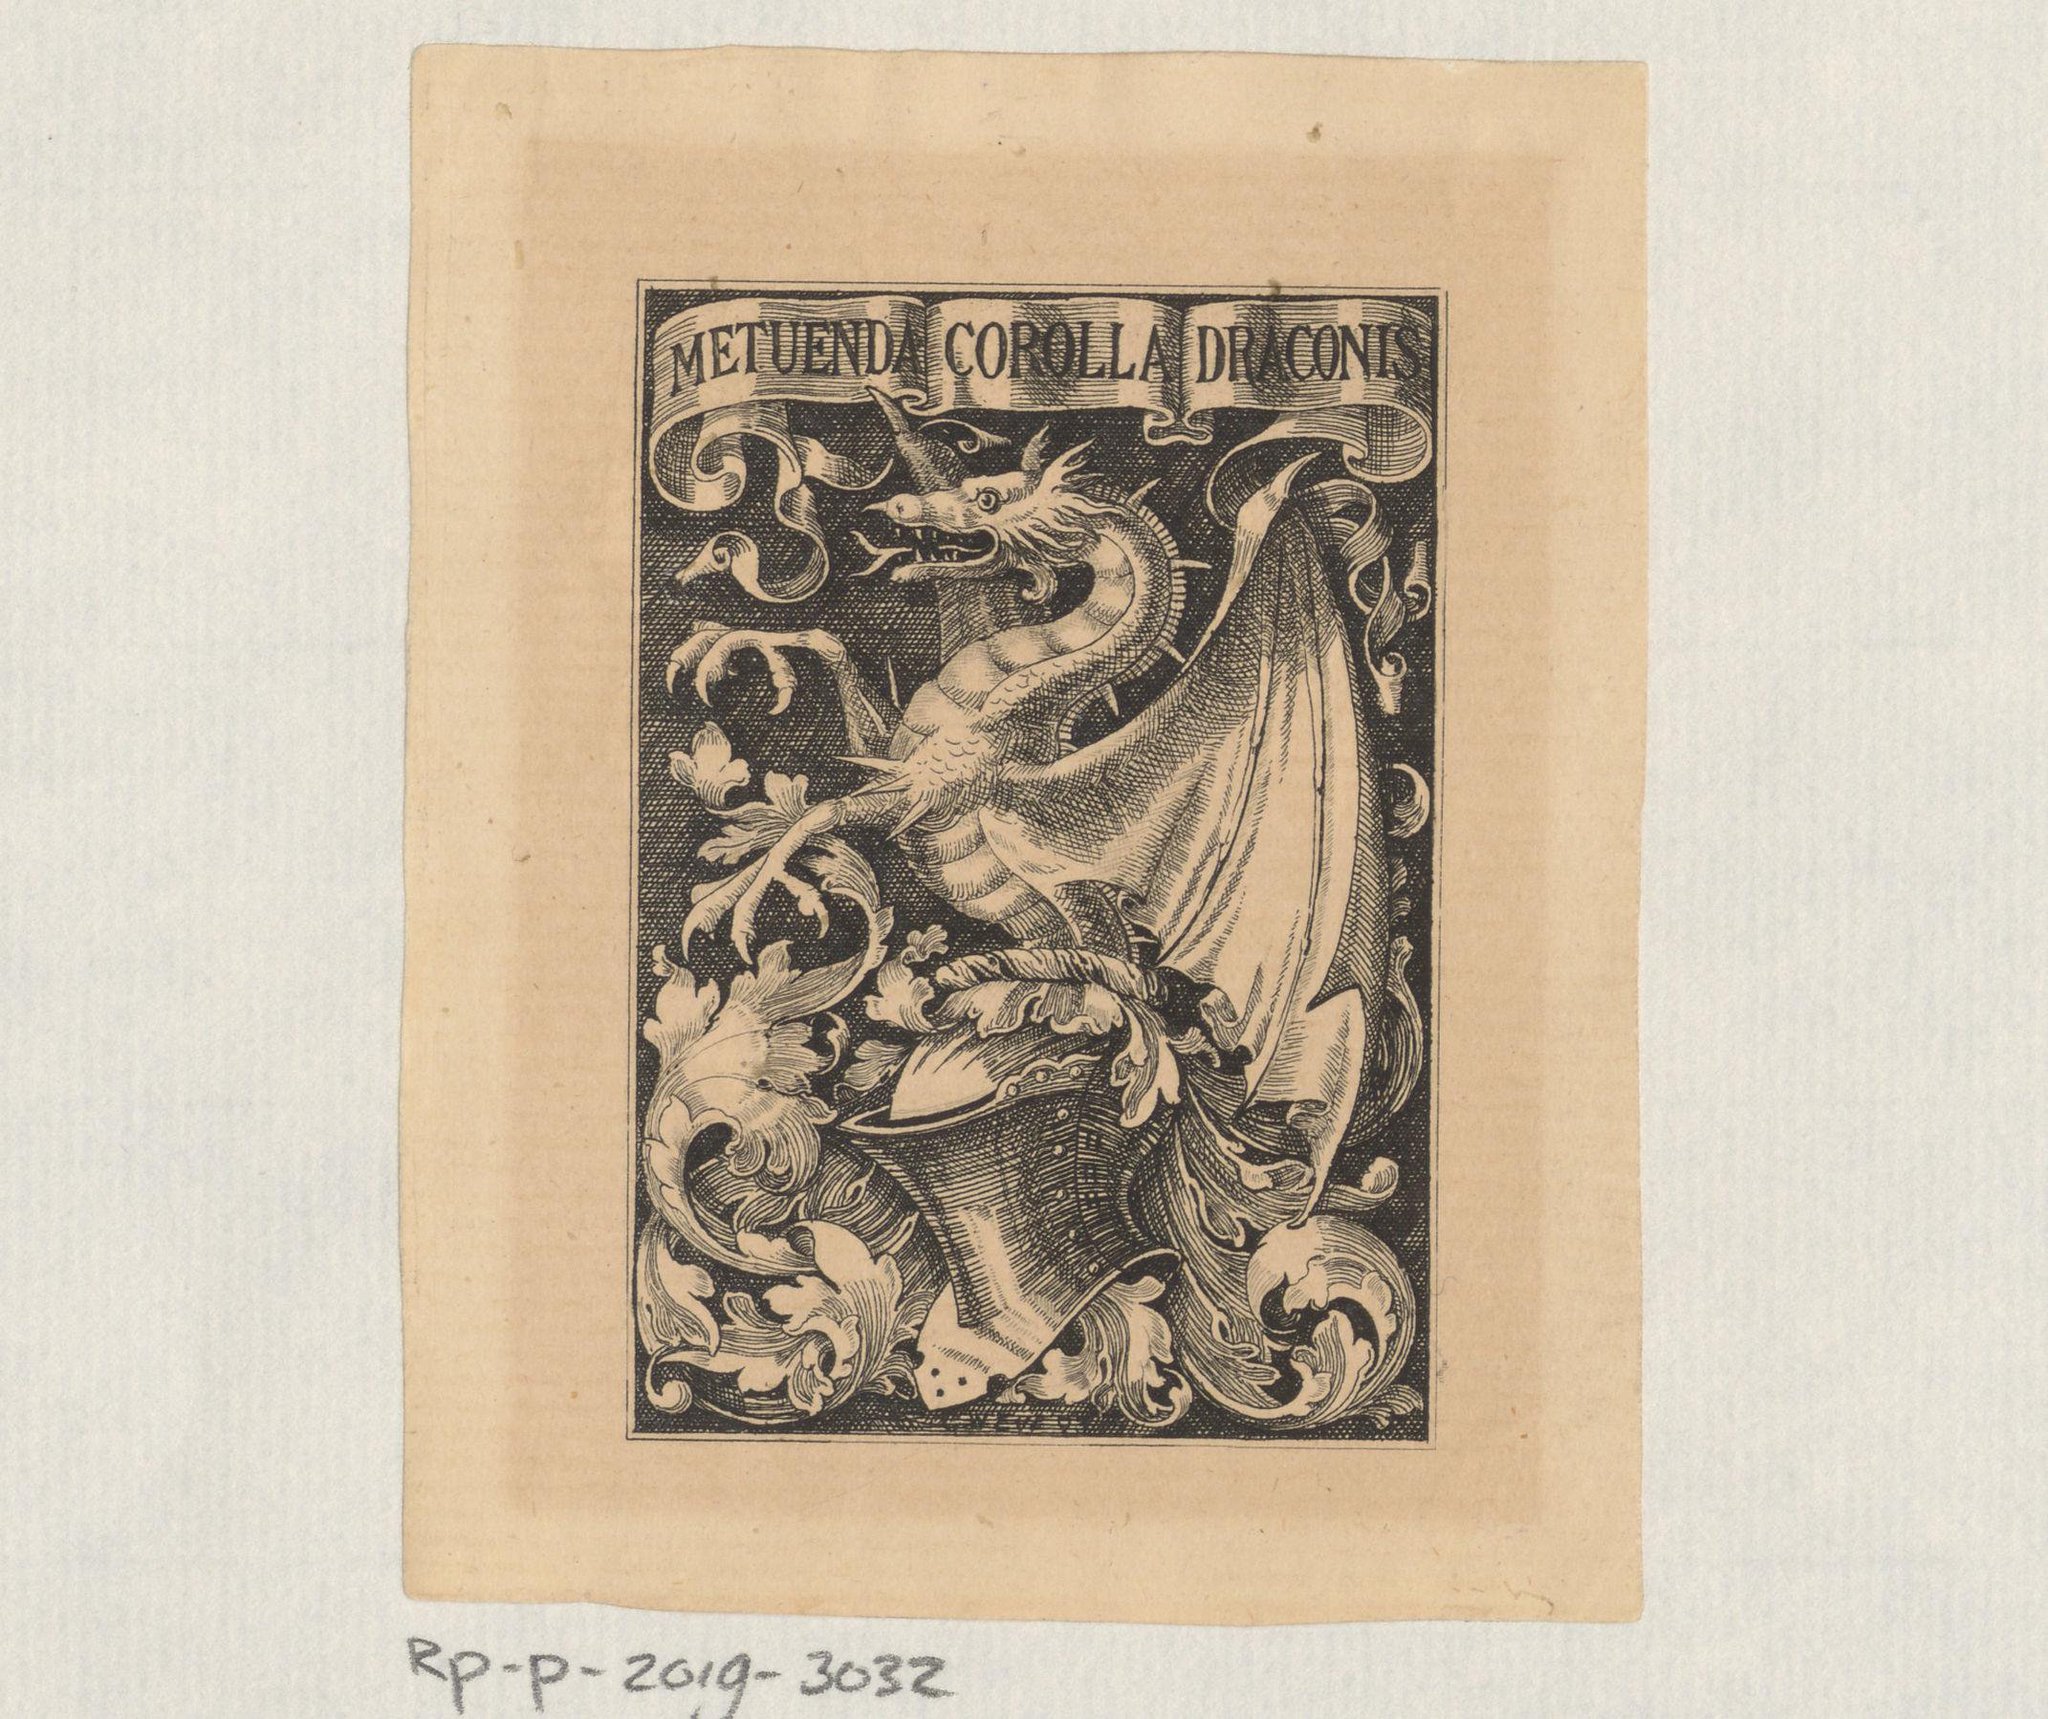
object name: bookplate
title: Ex libris van onbekend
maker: george william eve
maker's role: print maker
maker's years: 1855-1914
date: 1865-1914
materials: paper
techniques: etching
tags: dragon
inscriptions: collector's mark: ‘Publio Libraries [...]’